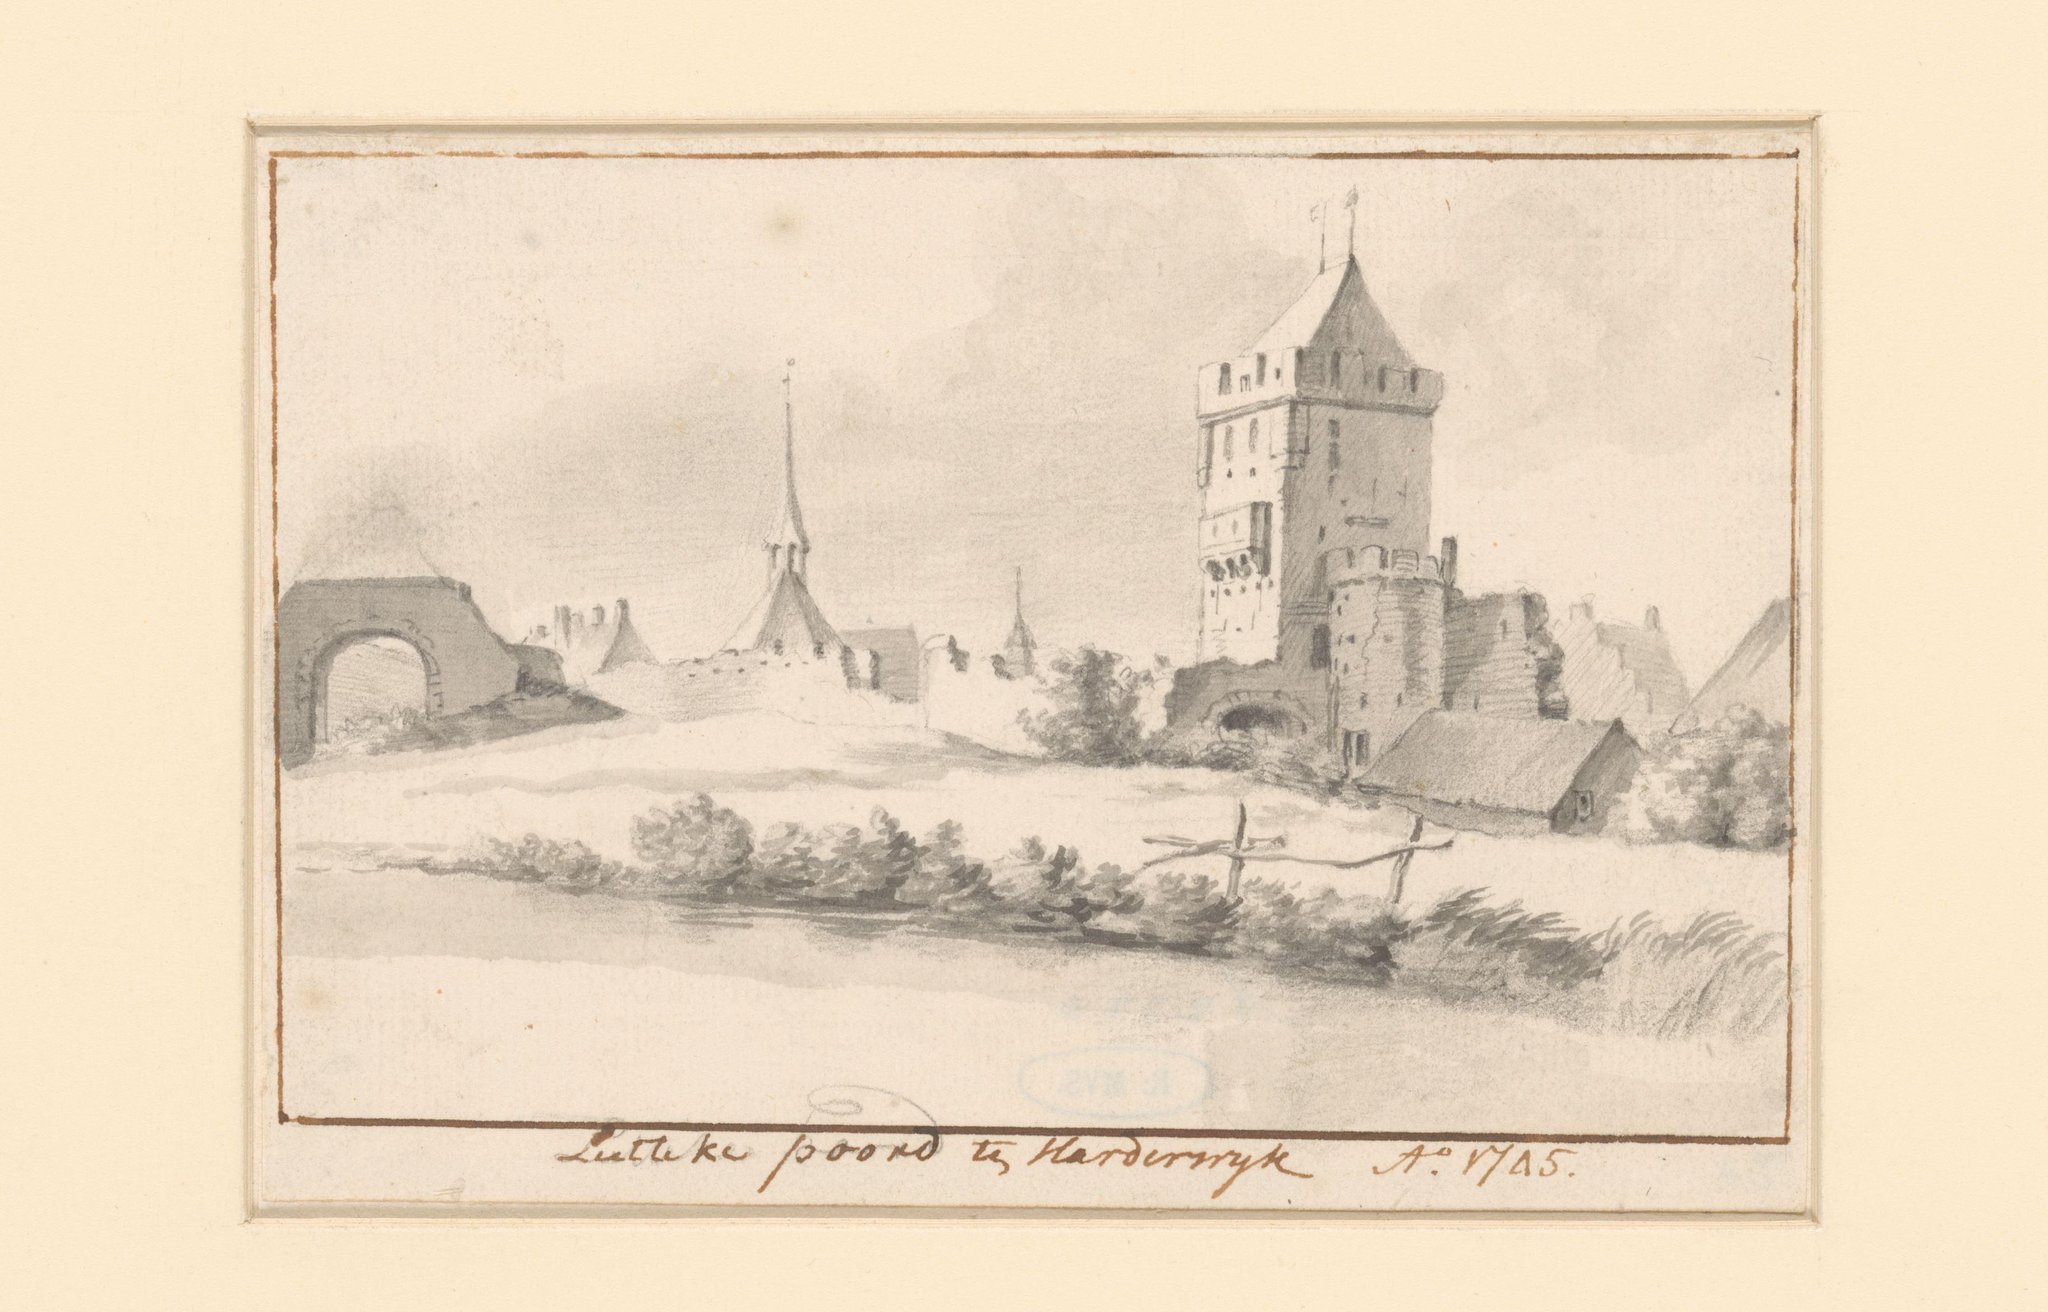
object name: drawing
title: Lutteke poord te Harderwijk Ao. 1745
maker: Anonymous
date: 1745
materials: ink, paper, pencil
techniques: brush, pen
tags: city-gate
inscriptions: collector's mark: Lugt 2228, inscription: ‘Lutteke poord te Harderwijk Ao. 1745’